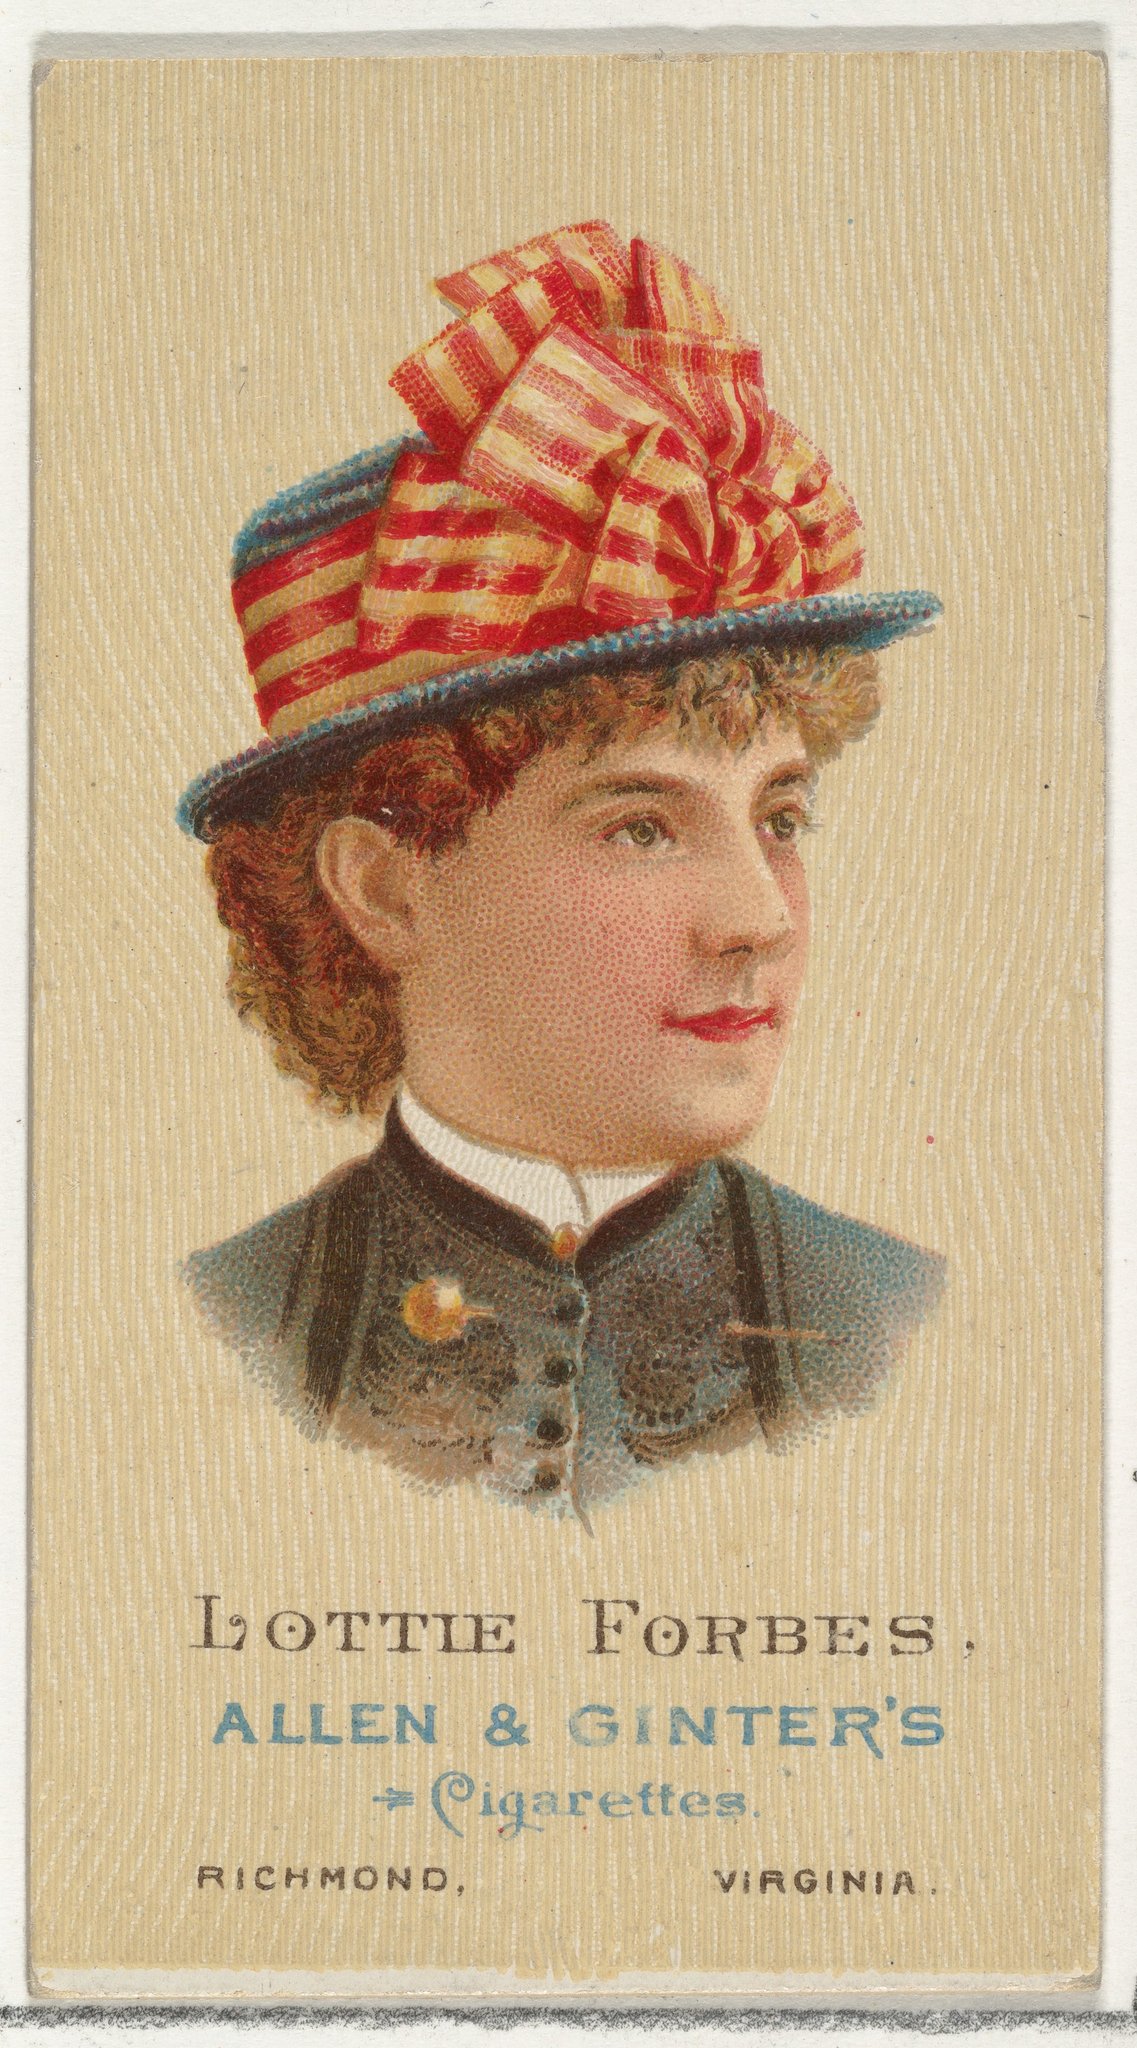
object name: print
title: Lottie Forbes, from World's Beauties, Series 2 (N27) for Allen & Ginter Cigarettes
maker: allen & ginter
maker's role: publisher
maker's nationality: american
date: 1888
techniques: color lithograph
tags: women